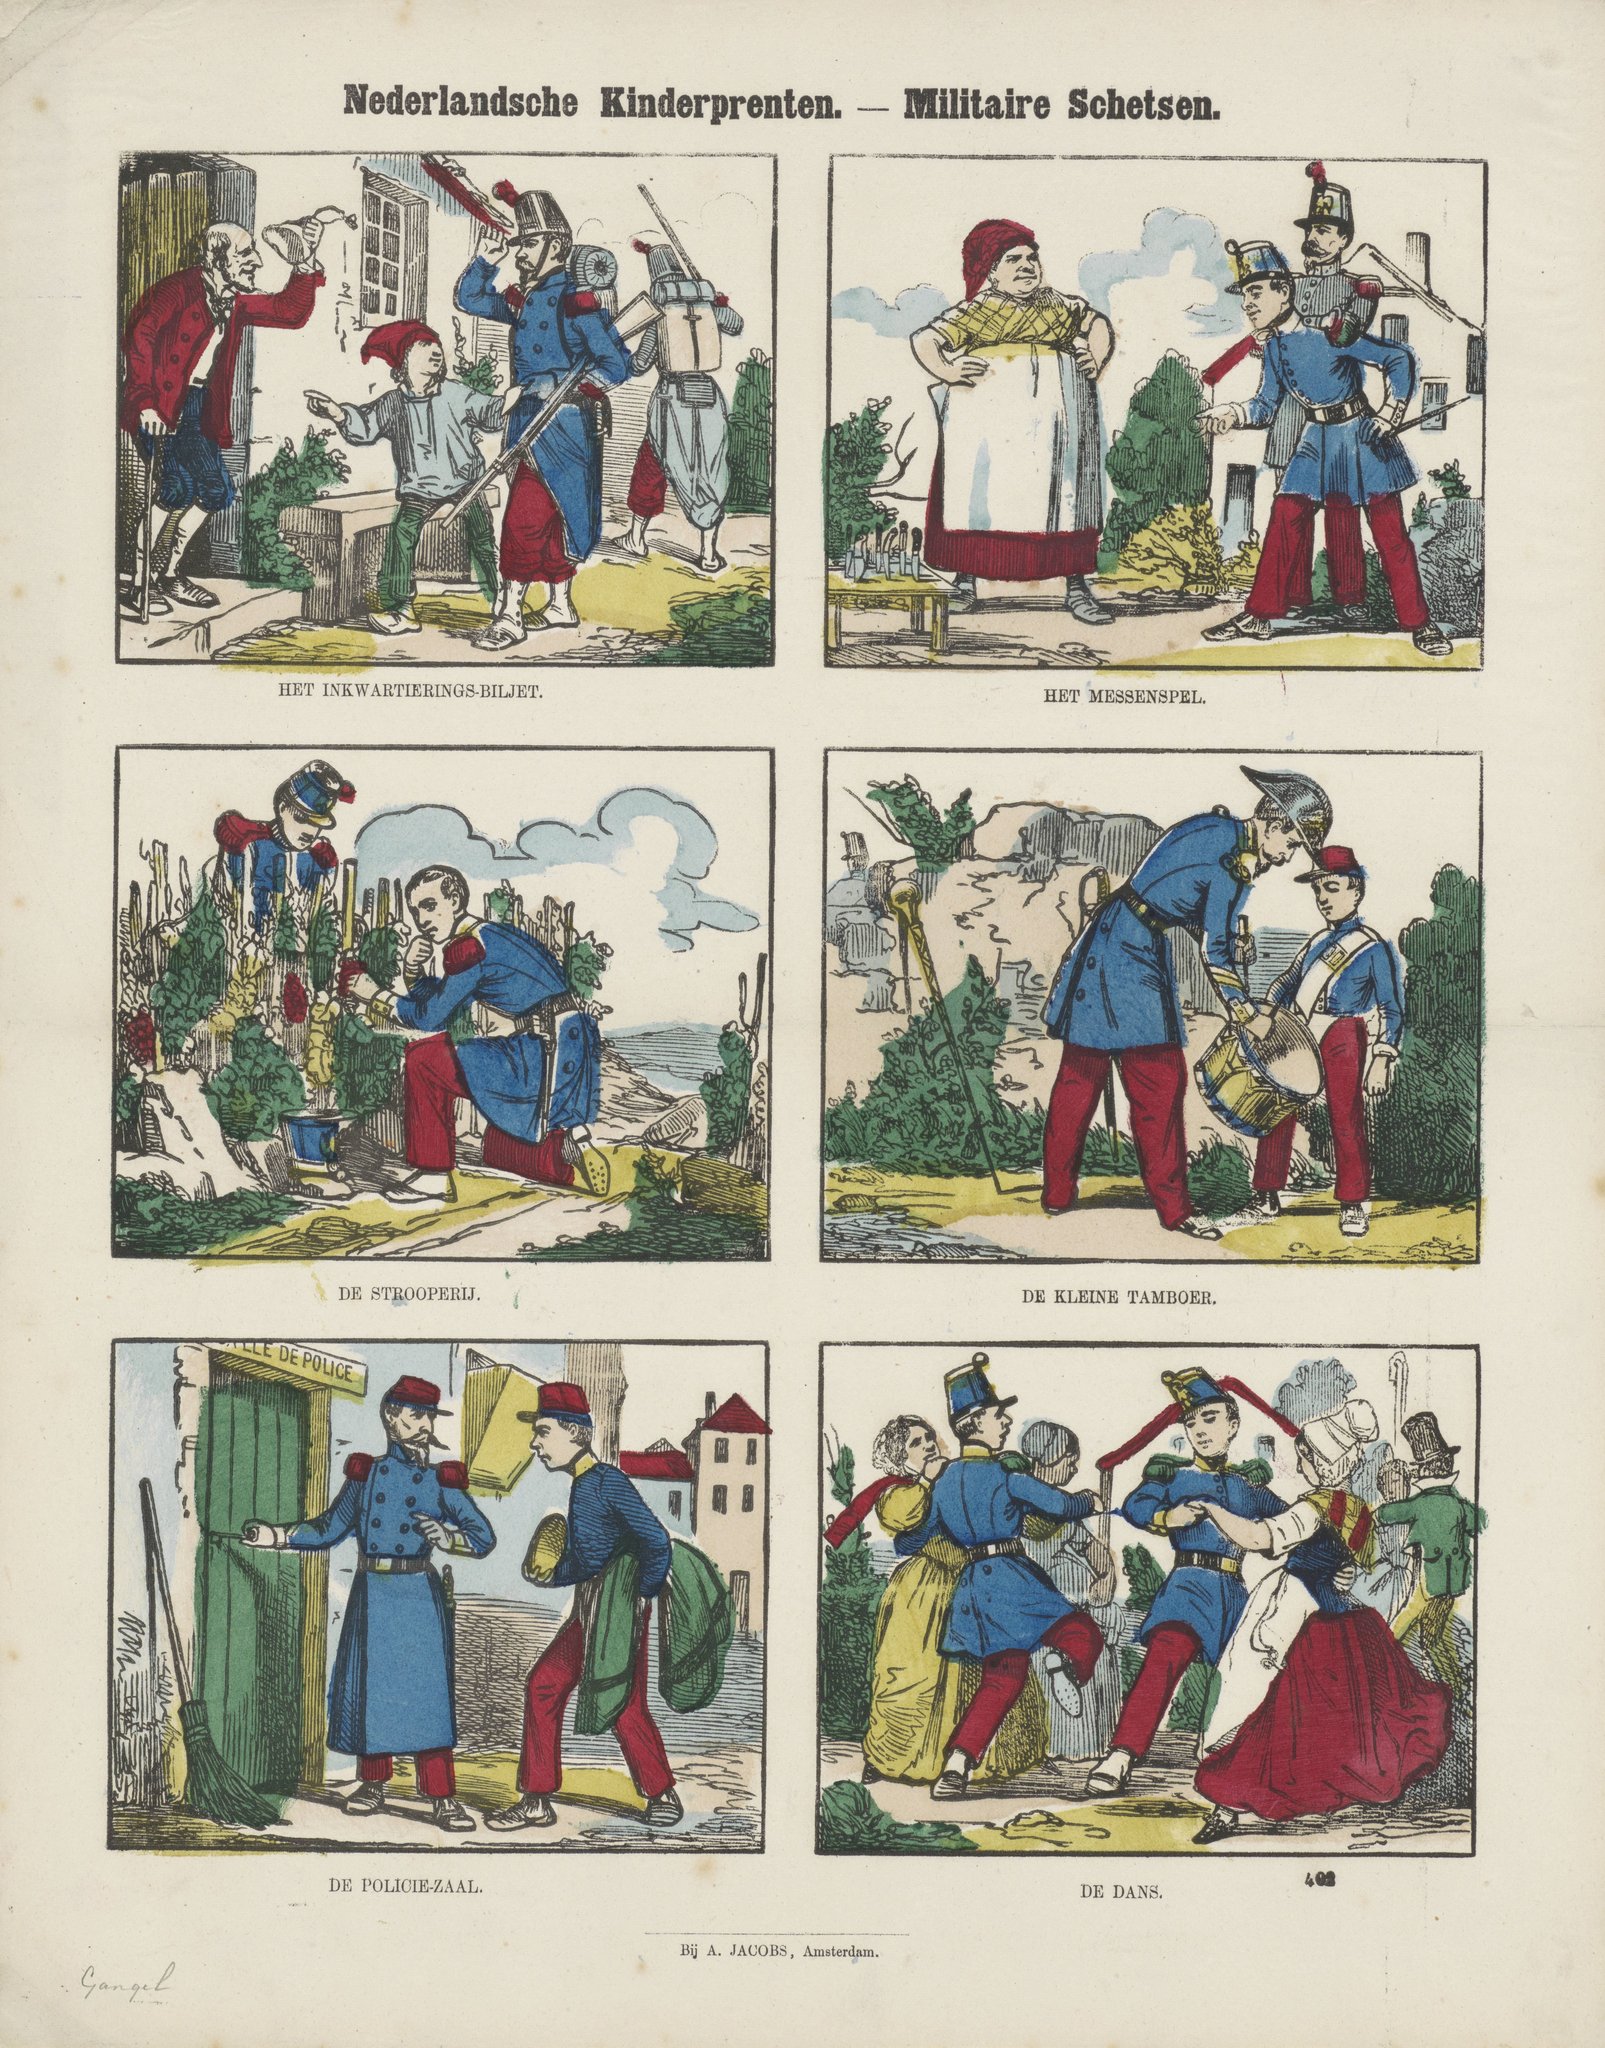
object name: popular print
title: Militaire schetsen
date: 1840-1868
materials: paper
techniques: hand coloring, letterpress printing, lithograph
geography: metz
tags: leave ~ the soldier off duty, the soldier; the soldier's life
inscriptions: collector's mark: Lugt 2760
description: Blad met 6 voorstellingen van militairen in verschillende situaties. Waaronder een militair die het messenspel speelt en dansende militairen. Onder elke afbeelding een onderschrift. Genummerd rechtsonder: 403.